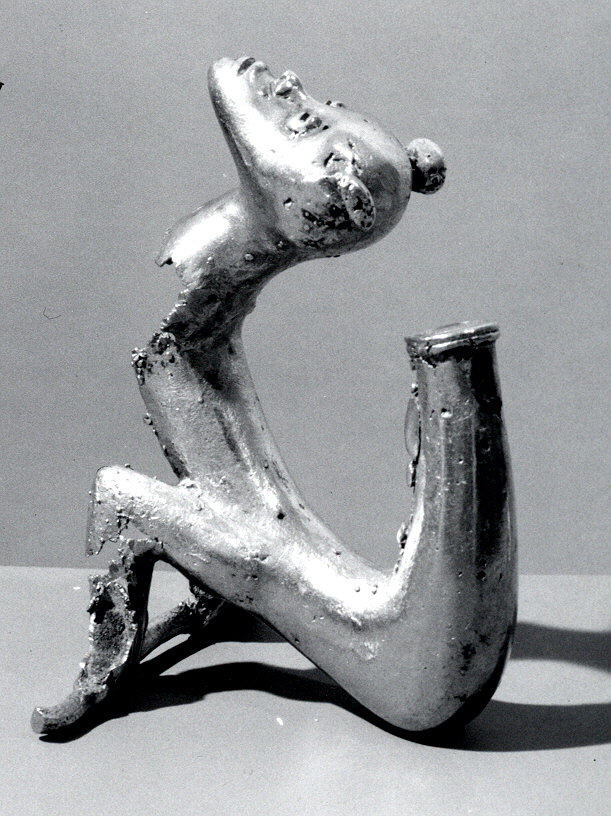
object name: pendant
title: Gold Curly Tailed Animal Pendant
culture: conte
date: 501-800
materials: gold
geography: panama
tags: animals